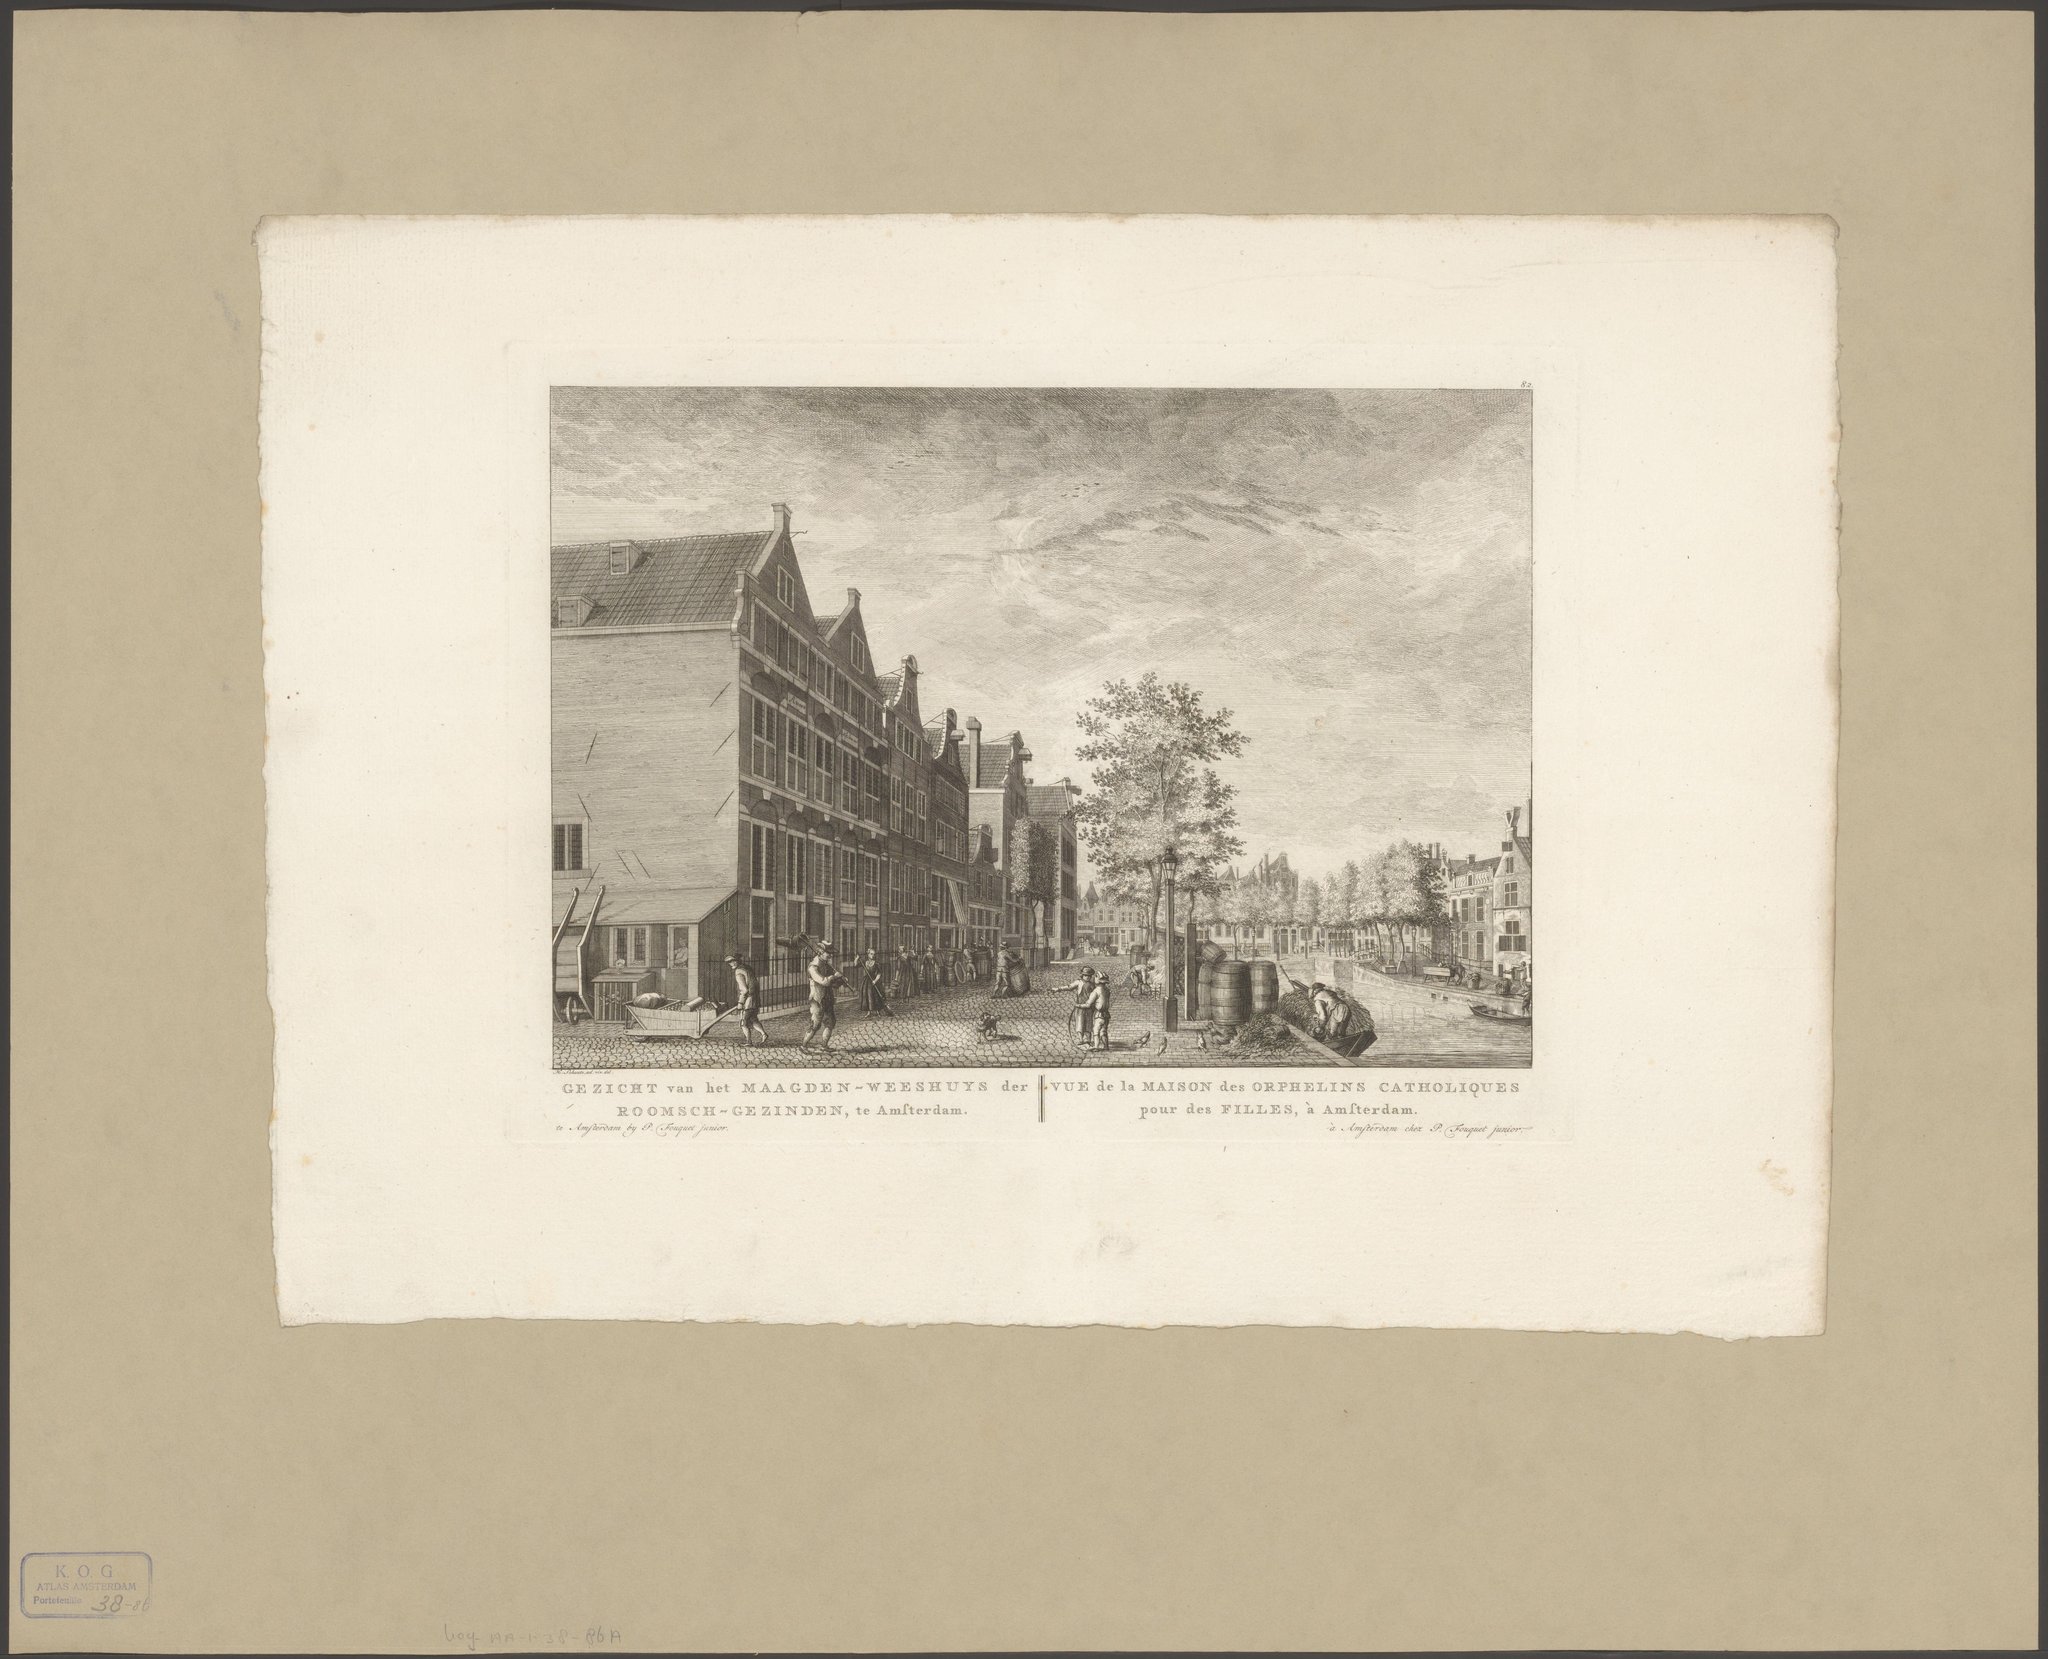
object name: print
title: Atlas van Fouquet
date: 1770-1783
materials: paper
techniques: engraving, etching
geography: amsterdam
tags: orphanage, canals, waters (in city) (+ city(-scape) with figures, staffage), street (+ city(-scape) with figures, staffage)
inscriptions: collector's mark: Lugt 1641b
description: Vanaf 1760 gaf Pierre Fouquet stadsgezichten van Amsterdam naar tekeningen van verschillende kunstenaars uit. Deze prenten werden aanvankelijk los verkocht. Later werden ze samengebonden verkocht in verschillende volgordes en aantallen in: (1). Afbeeldingen van de wyd-vermaarde koopstad Amsterdam benevens des zelvs voornaamste gebouwen en gezigten alle naar het leeven getekend / Receuil des edifices les plus considerables et des plus belles vues, de la fameuse ville d'Amsterdam, dessinées d'après nature. Amsterdam: Pierre Fouquet, 1778-1783. Deze 'uitgave' bestond waarschijnlijk alleen uit een titelblad en inhoudsopgave van de tot dusver 100 uitgegeven prenten, die de koper zelf aan zijn of haar reeds verzamelde prenten kon toevoegen. De hoeveelheid en volgorde van prenten verzameld onder deze titel verschilt dus sterk. (2). Nieuwe atlas, van de voornaamste gebouwen en gezigten der stad Amsterdam, met derzelver beknopte beschryvingen. 2 dln. Amsterdam: Daniël Jean Changuion en Petrus den Hengst [in opdracht van Pierre Fouquet], 1783. Ook werden er door verschillende uitgevers tussen 1788 (Amsterdam: Petrus Conradi) en 1805 (Amsterdam: Evert Maaskamp) heruitgaven gepubliceerd.